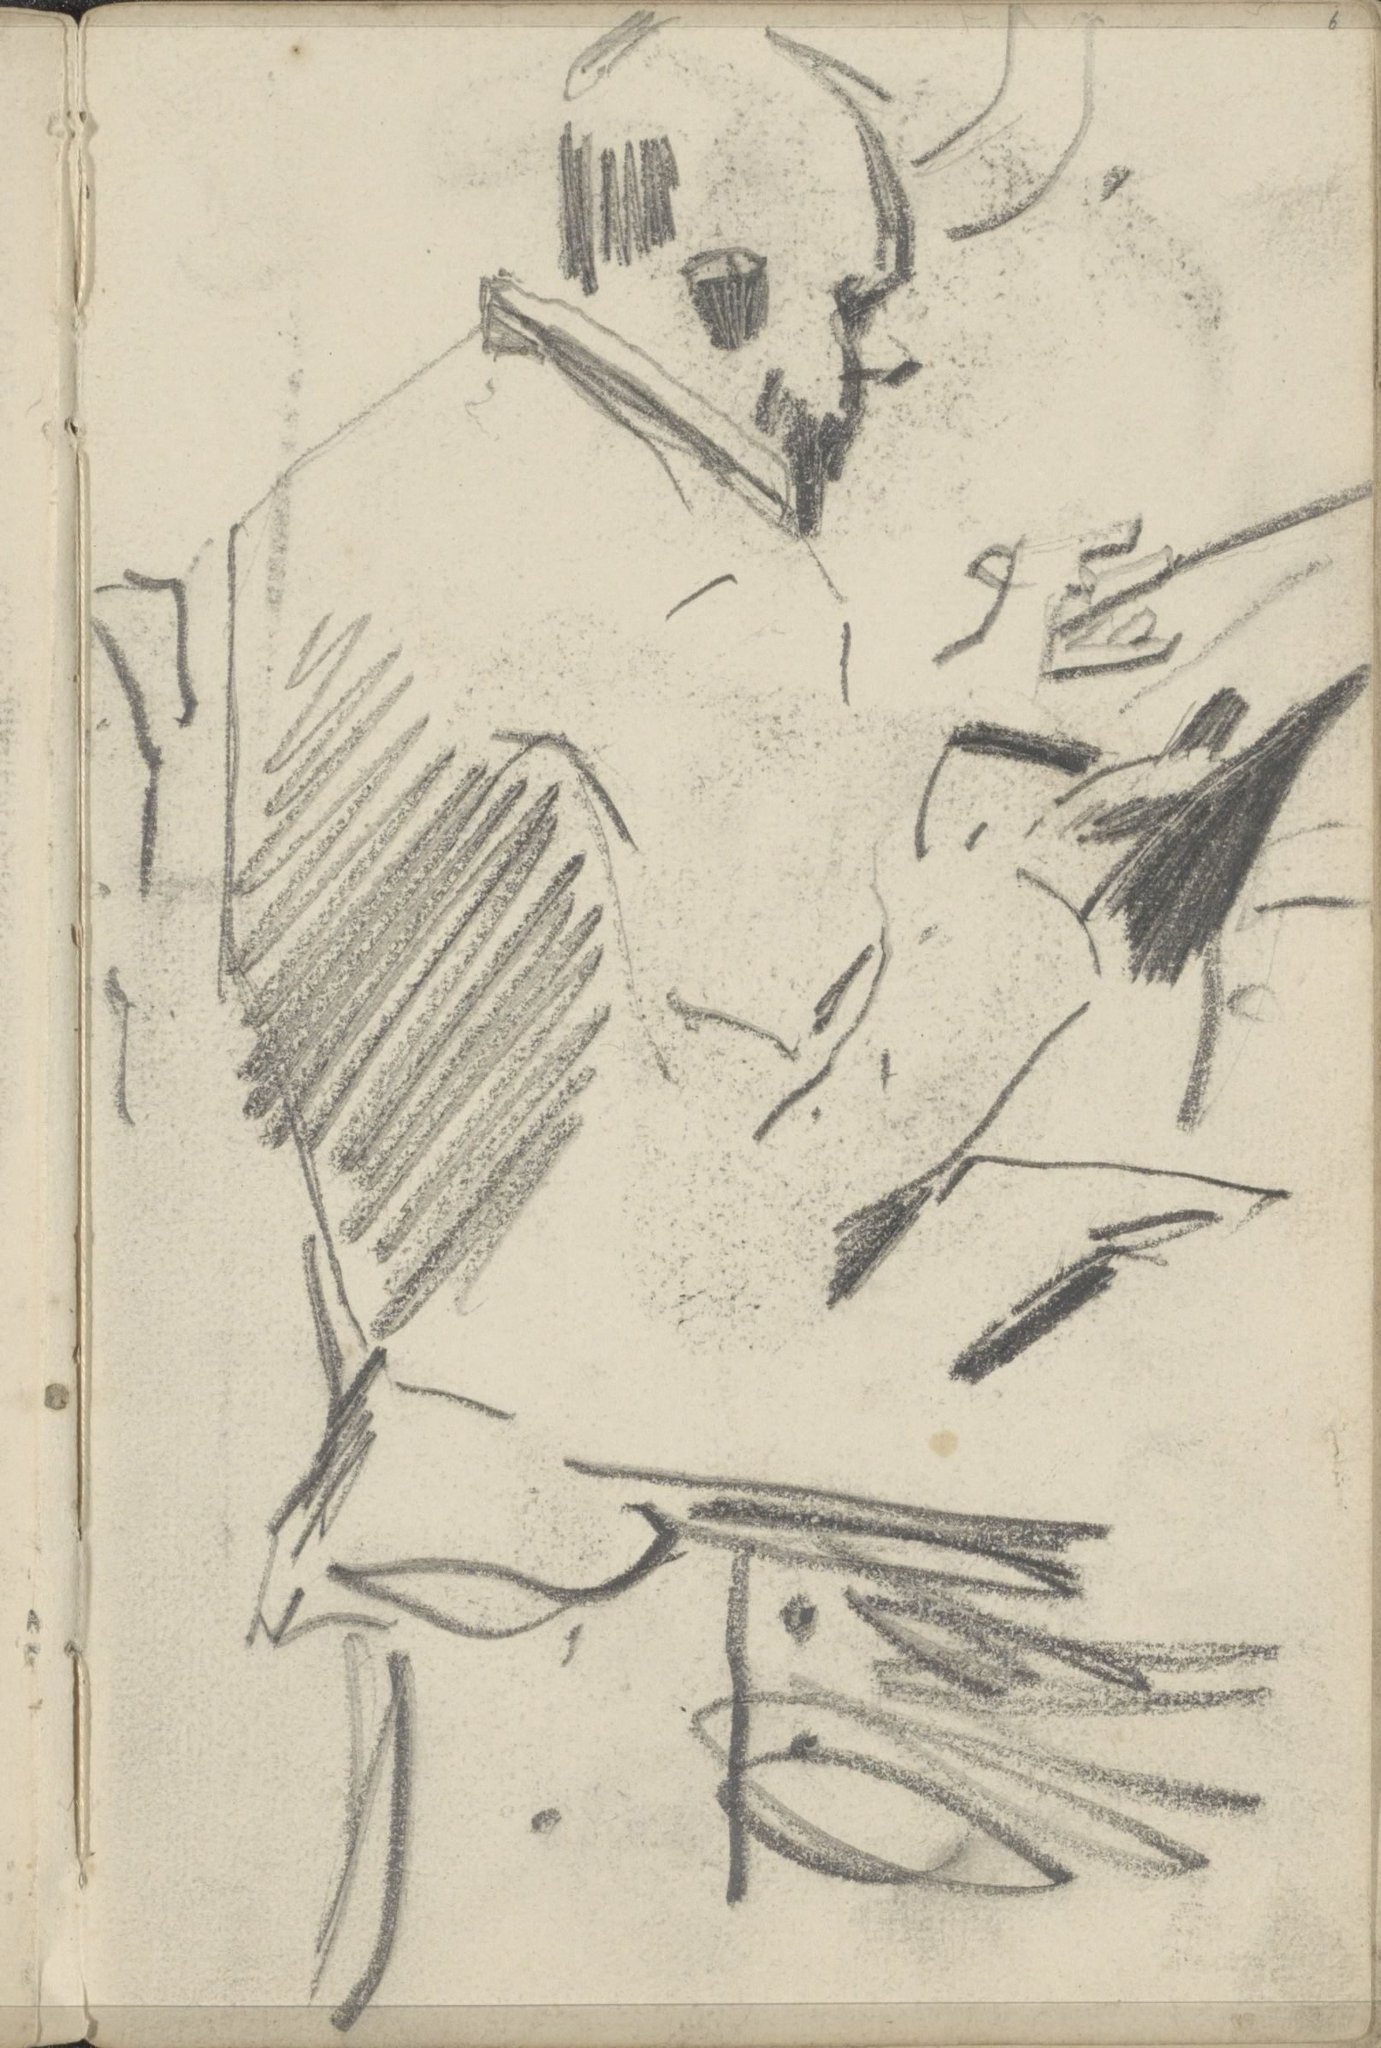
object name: sketchbook leaf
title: Zittende man, mogelijk schrijvend of tekenend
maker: george hendrik breitner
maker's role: draughtsman, painter, print maker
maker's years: 1857-1923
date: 1887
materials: paper, pencil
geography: amsterdam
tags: rotterdam, print maker, draughtsman, george hendrik breitner, writing-table, writing-desk, sitting figure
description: Mogelijk een zelfportret. Pagina 6 uit een schetsboek met 12 bladen.